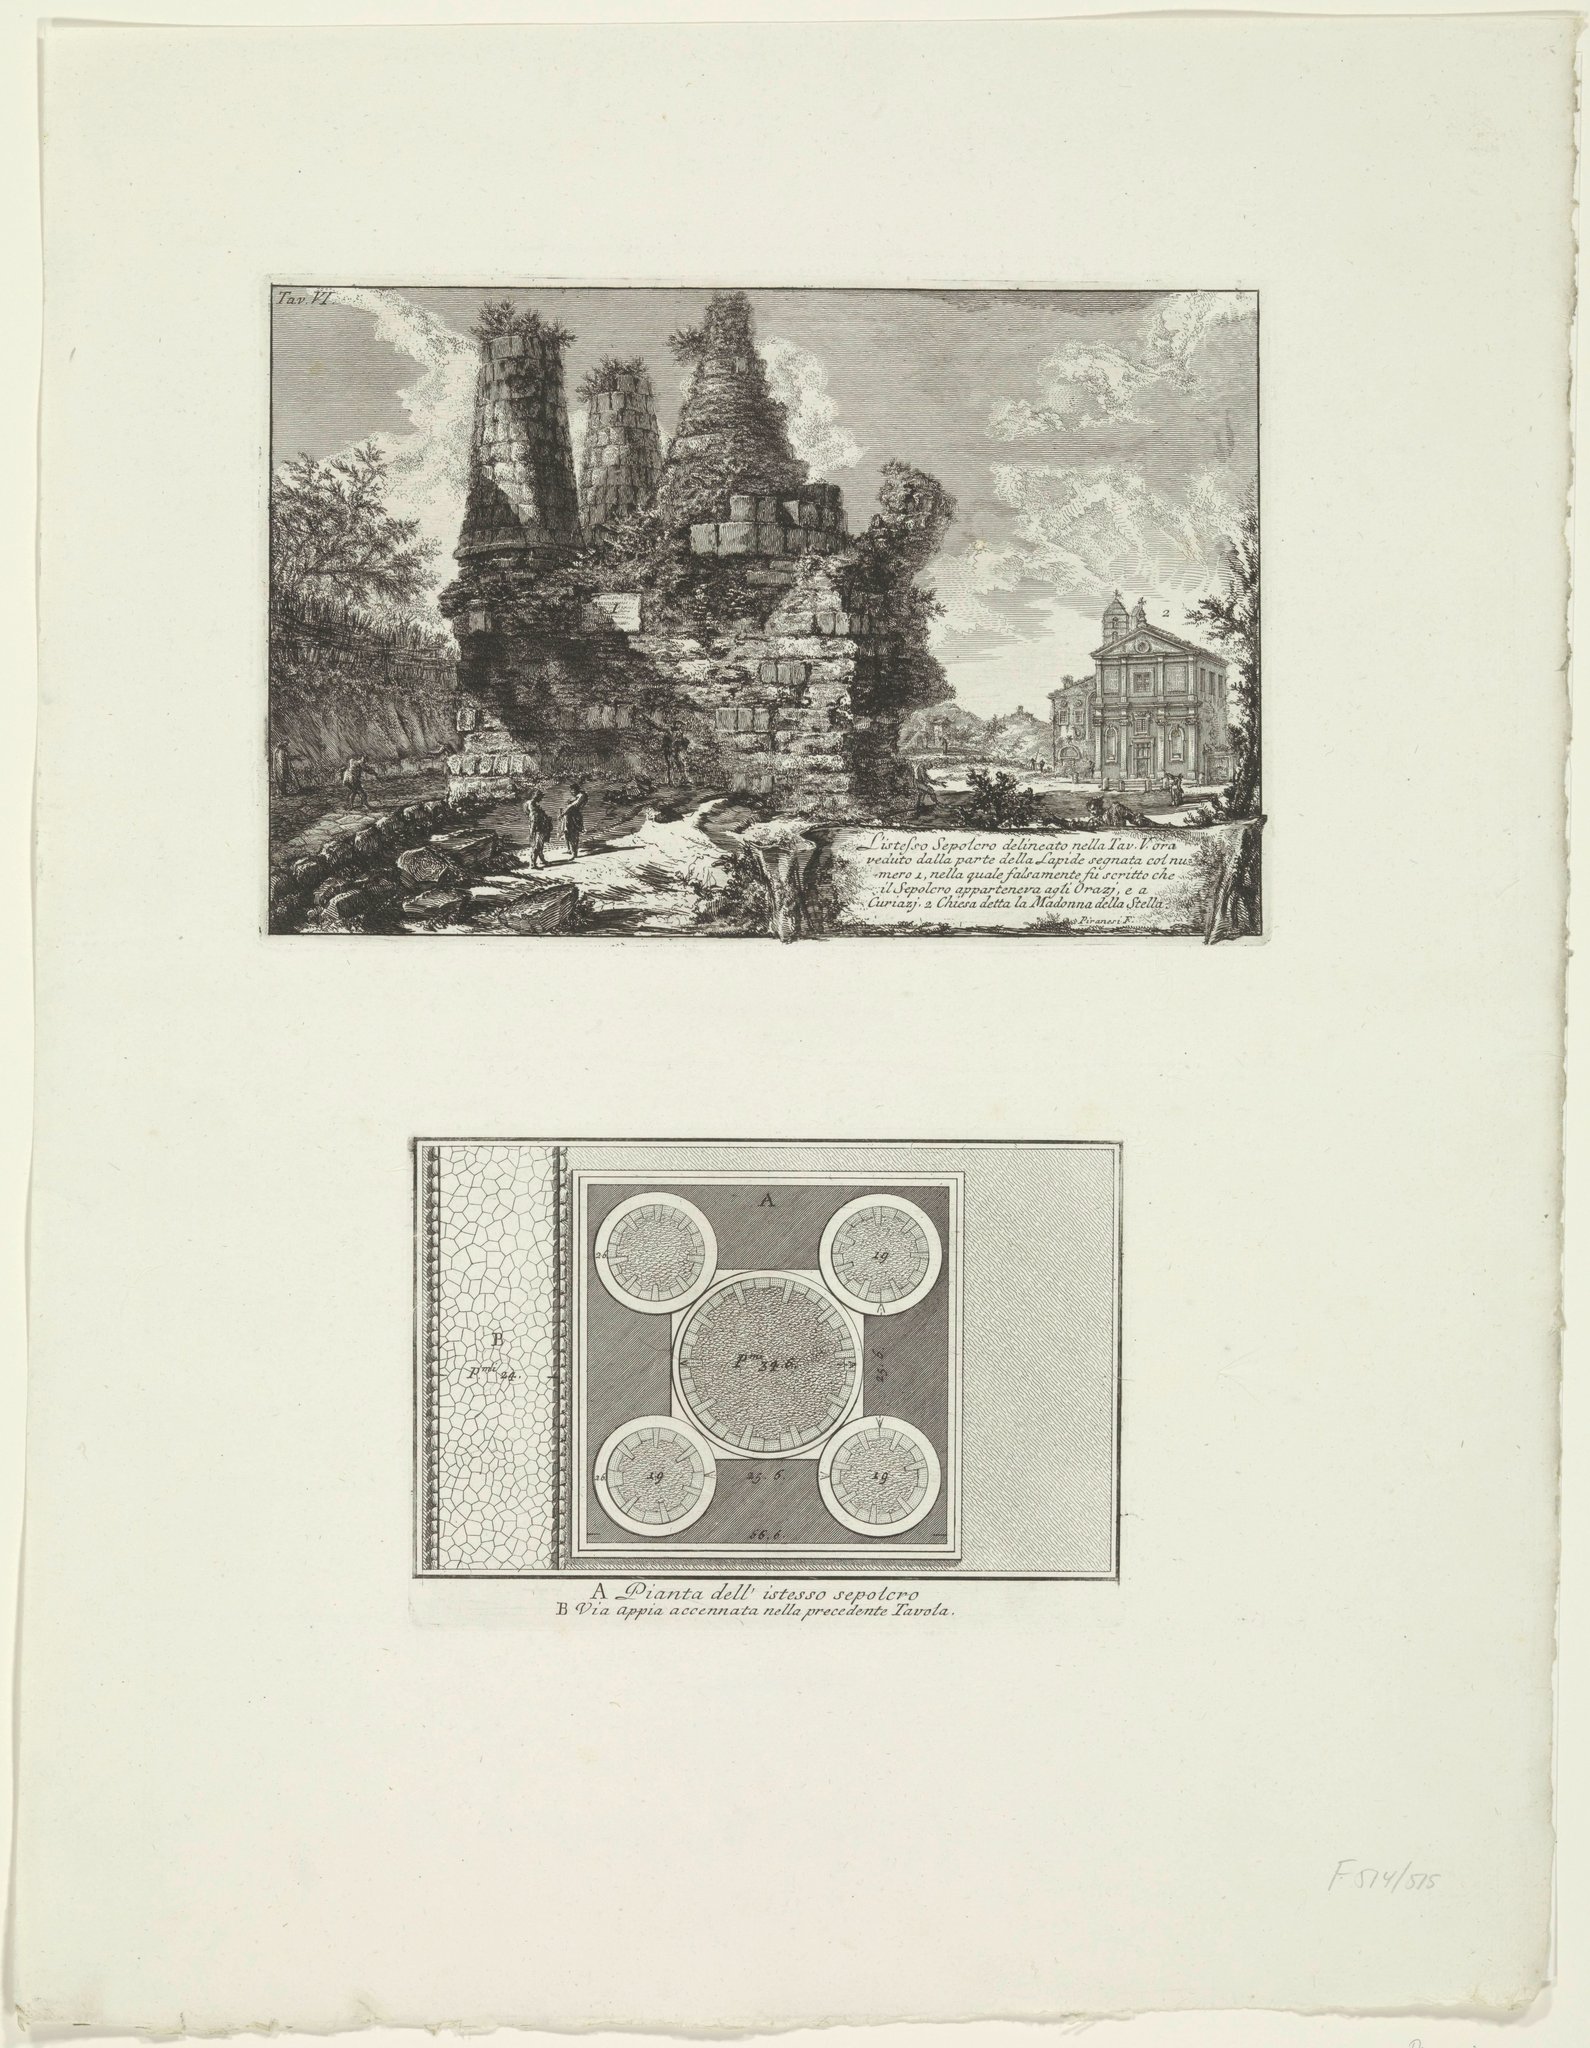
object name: print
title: Antichità d'Albano e di Castel Gandolfo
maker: giovanni battista piranesi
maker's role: designer, draughtsman, print maker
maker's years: 1720-1778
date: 1762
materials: paper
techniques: etching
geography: rome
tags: ruin of a building ~ architecture, the curiatii, three brothers from alba longa, (story of) the horatii, three brothers from rome, grave-building, monumental tomb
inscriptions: collector's mark: Lugt 2228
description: Blad met twee voorstellingen van de graftombe van de Horatii en Curiatii gelegen tussen Albano en Ariccia. Boven: begroeide restanten met drie van de oorspronkelijk vijf torens van de graftombe. Rechts op de achtergrond de kerk Madonna della Stella. Genummerd linksboven: Tav. VI. Onderschrift en verklarende lijst met nummers in ondermarge. Onder: een reconstructie van de plattegrond van de graftombes. De tombe zou hebben bestaan uit vijf gedeelten voor de vijf mannen die sneuvelden tijdens de strijd tussen de Horatii en Curiatii. Verklarende lijst met letters in ondermarge.